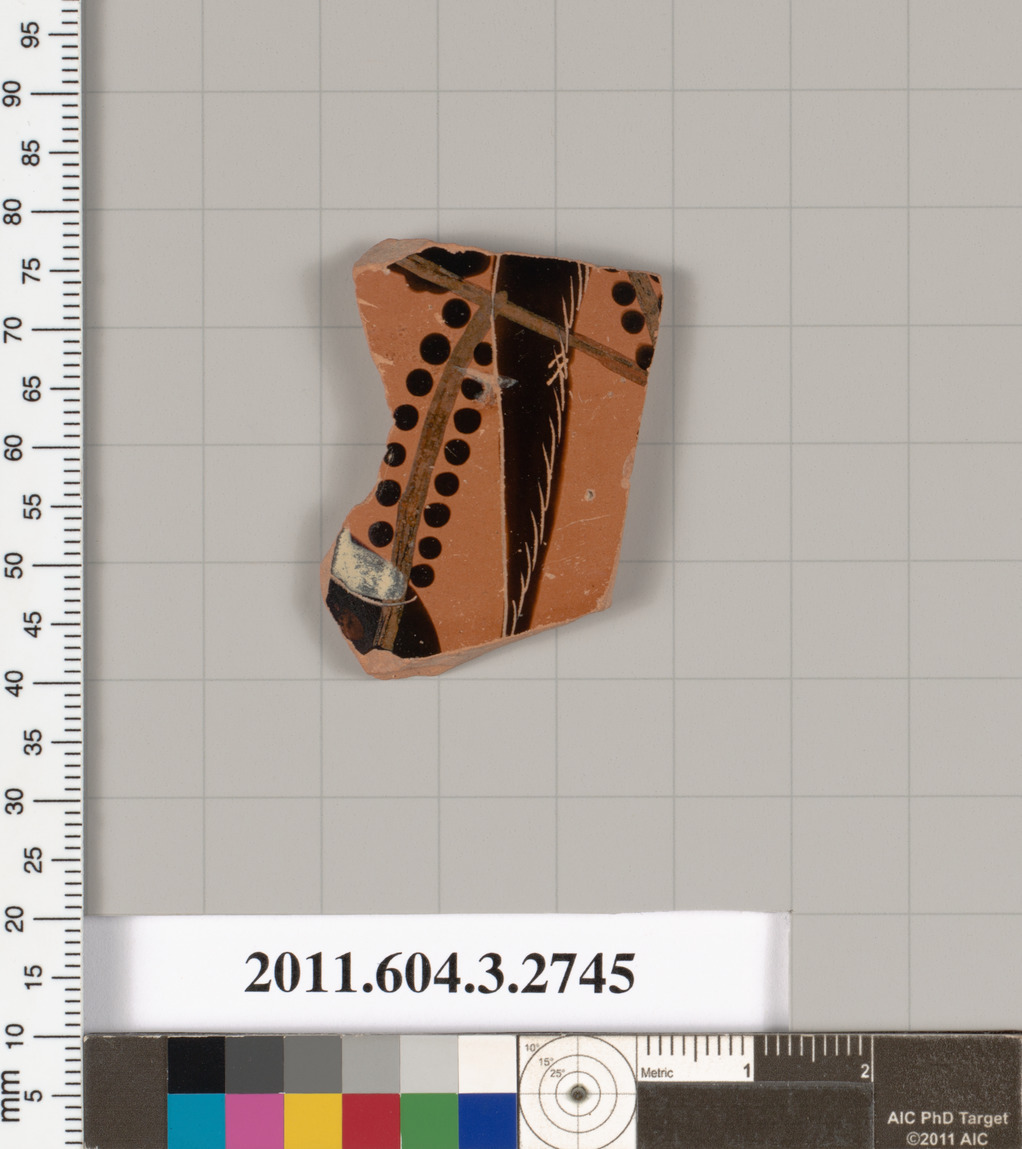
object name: oinochoe or olpe fragment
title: Terracotta fragment of an oinochoe (jug) or olpe (jug)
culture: greek, attic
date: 520-500 BCE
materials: terracotta